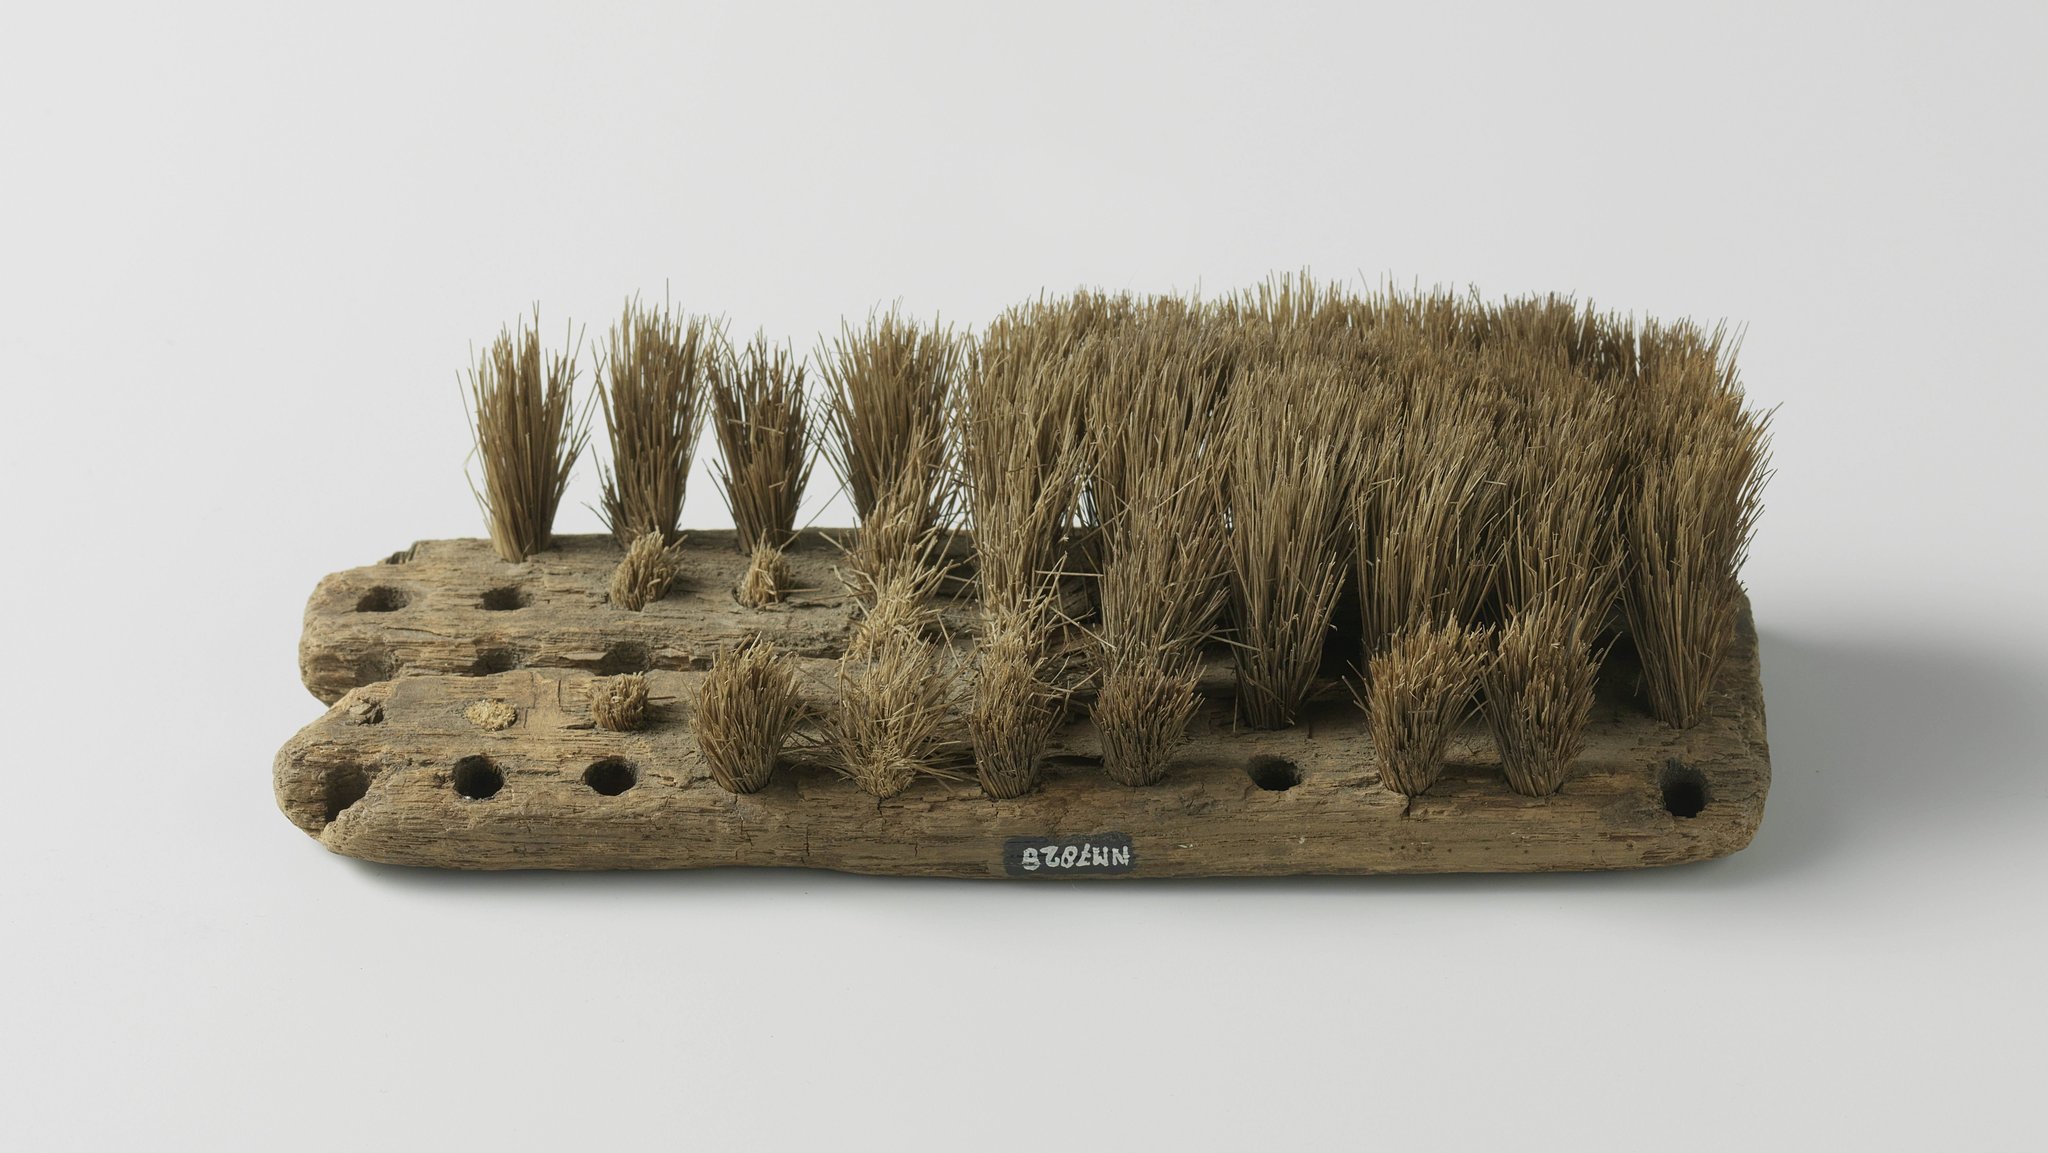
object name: boender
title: Household effects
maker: Anonymous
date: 1590-1596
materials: hair, wood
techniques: cutting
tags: willem barendsz., amsterdam, jacob van heemskerck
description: Among the remnants from the ‘Safe House’ were many utilitarian household objects, such as plates, cutlery and brushes. The taps originally were attached to wooden barrels containing water or wine. The ‘spike candleholders’, which could be hammered into a wooden beam, were particularly convenient.